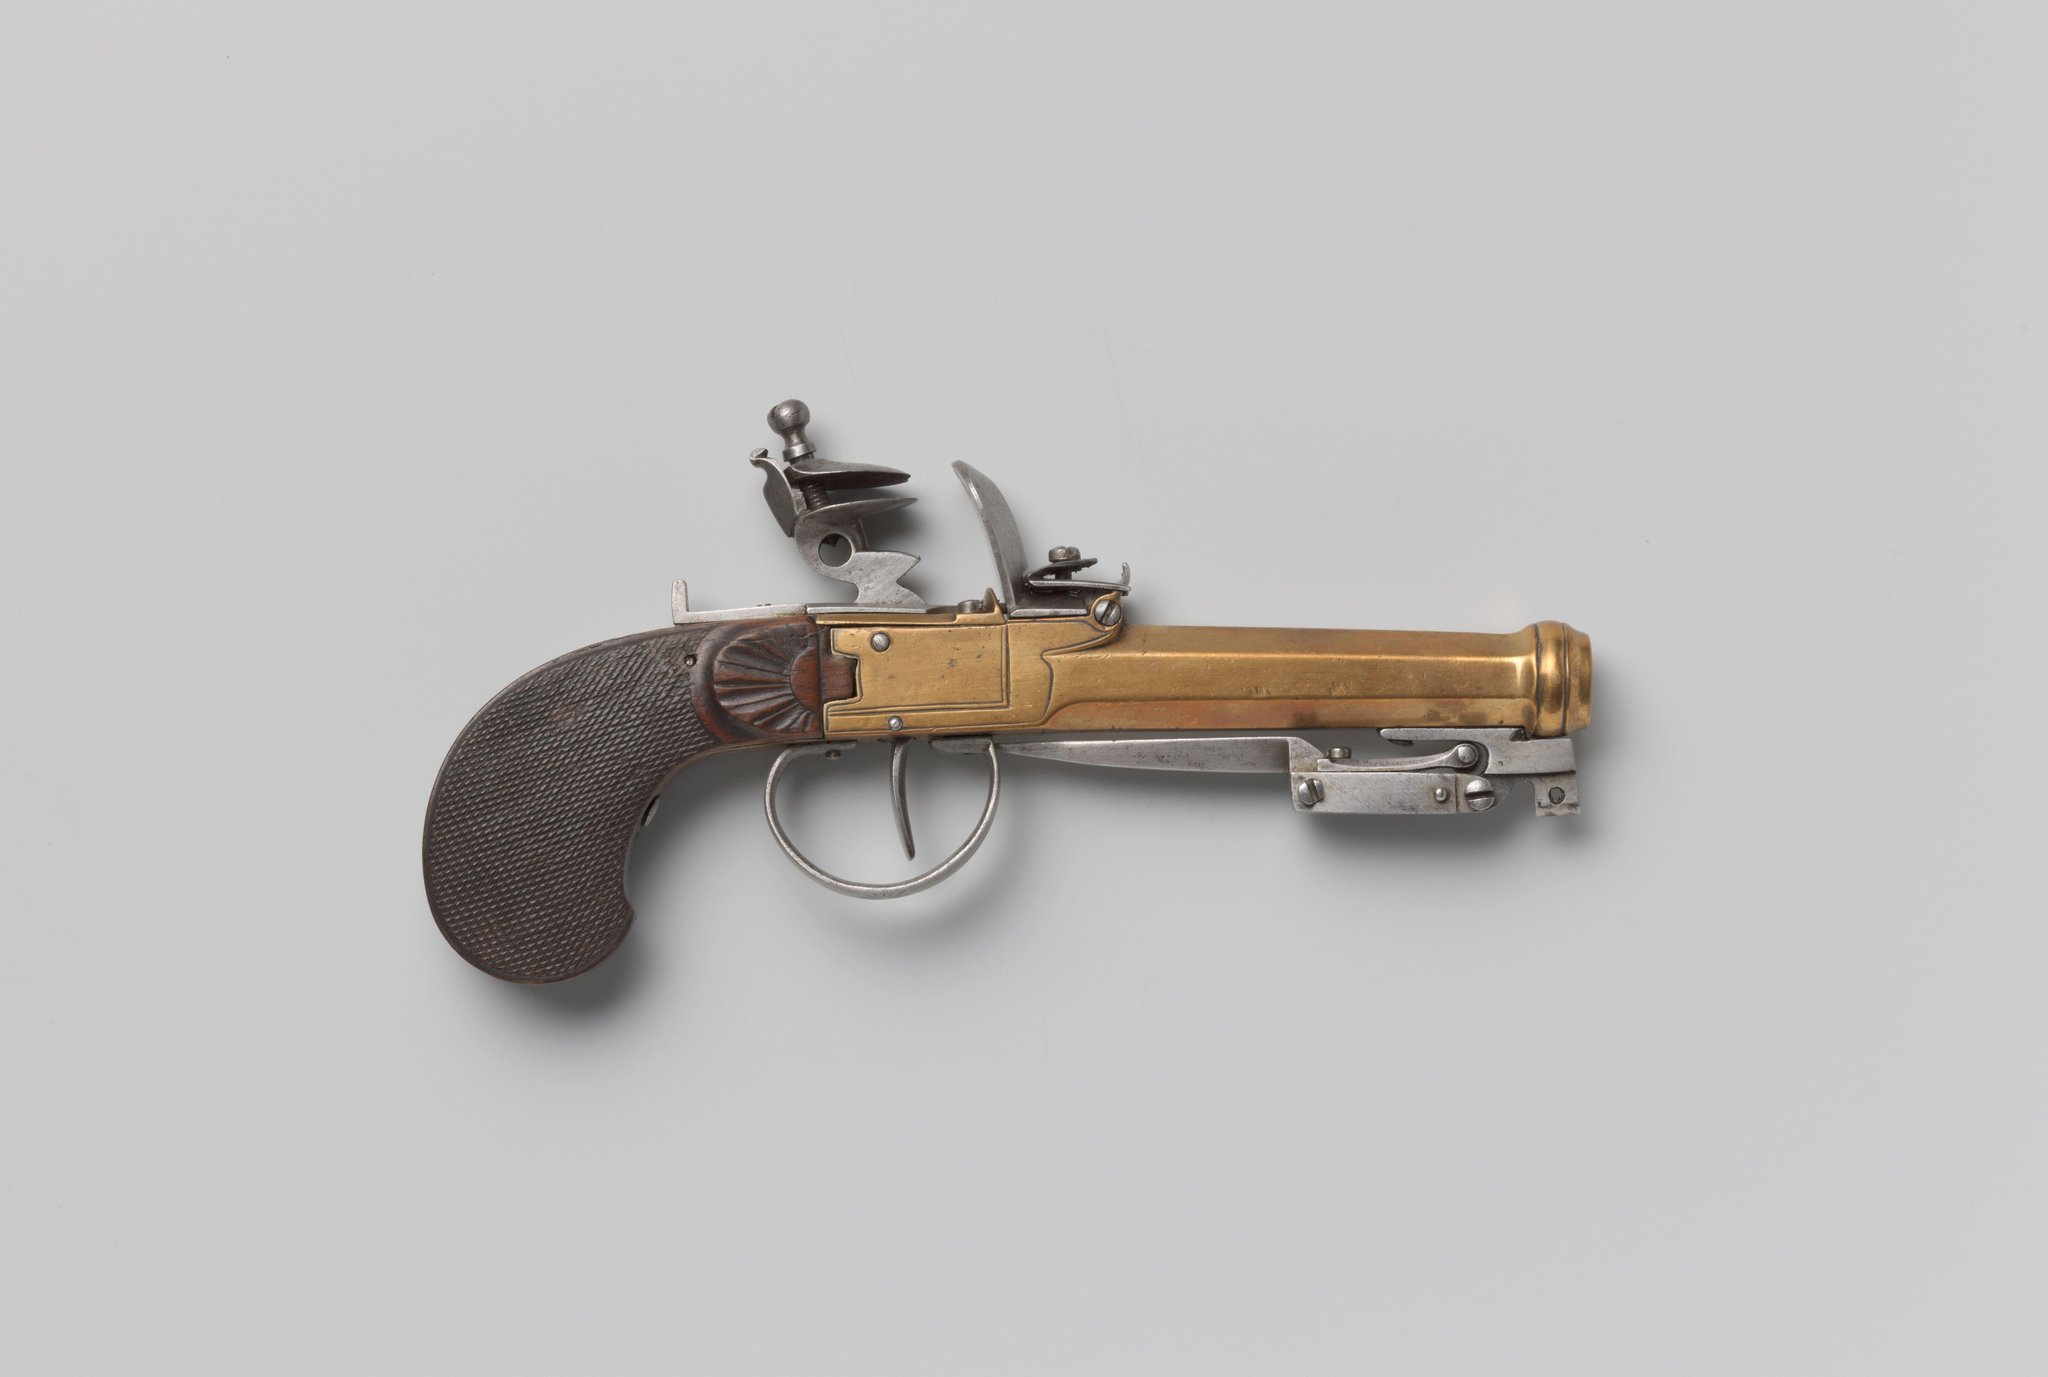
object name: pocket pistol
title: Zakpistool met kastslot van Generaal baron Chassé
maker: Anonymous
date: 1765-1850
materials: copper, iron, wood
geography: liège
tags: david hendrik baron chassé, antwerp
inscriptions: mark: ‘ELG’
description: Vuursteenpistool met achthoekige koperen loop waarvan uiteinde geprofileerd is. Onder de loop een opklapbare bajonet. De kolf is ruitvormig gegroefd. Pistool heeft een inwendig slot, ijzeren haan, pan en vuurstaal bevinden zich op het slot. Zijkanten van de lade zijn schelpvormig gesneden uit hout. De trekkerbeugel is van ijzer met aan de onderzijde een ingekerfde ster. Ter linkerzijde van de loop een ovaal met Luikse keurmerk ELG in gegraveerd. Pistool behoord hebbende aan baron D.H. Chassé, luitenant-generaal opperbevelhebber van de Citadel van Antwerpen.